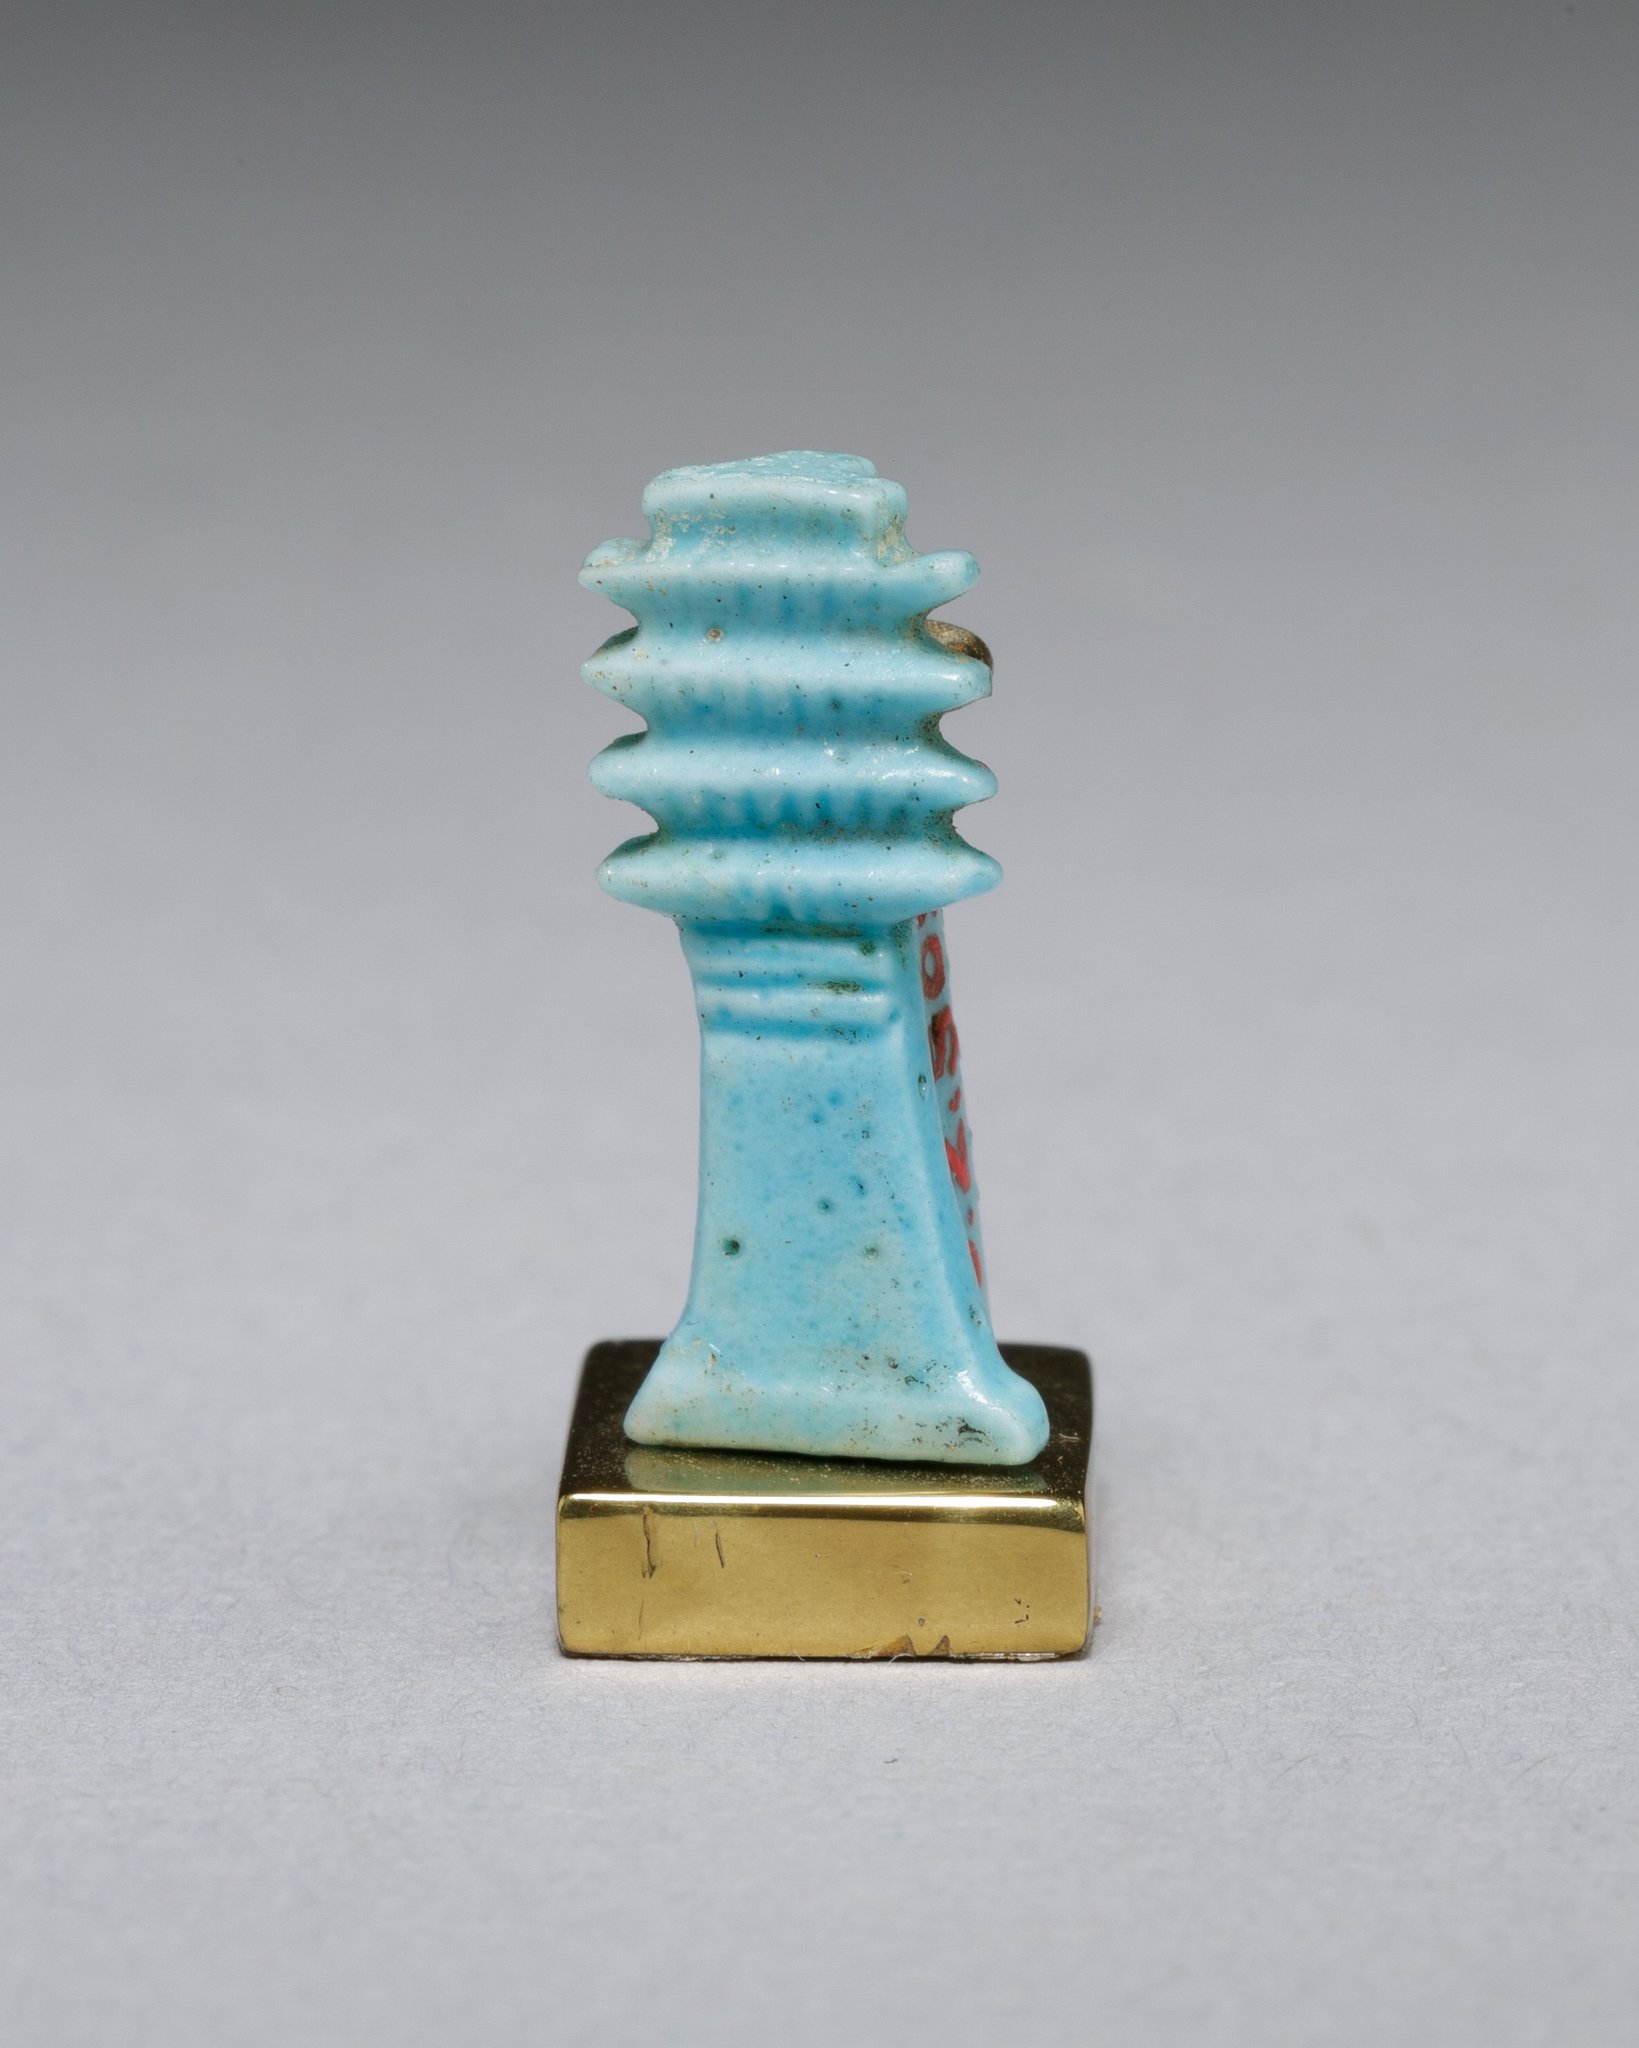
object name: amulet, djed pillar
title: Djed Pillar Amulet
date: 664-630 BCE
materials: faience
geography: egypt